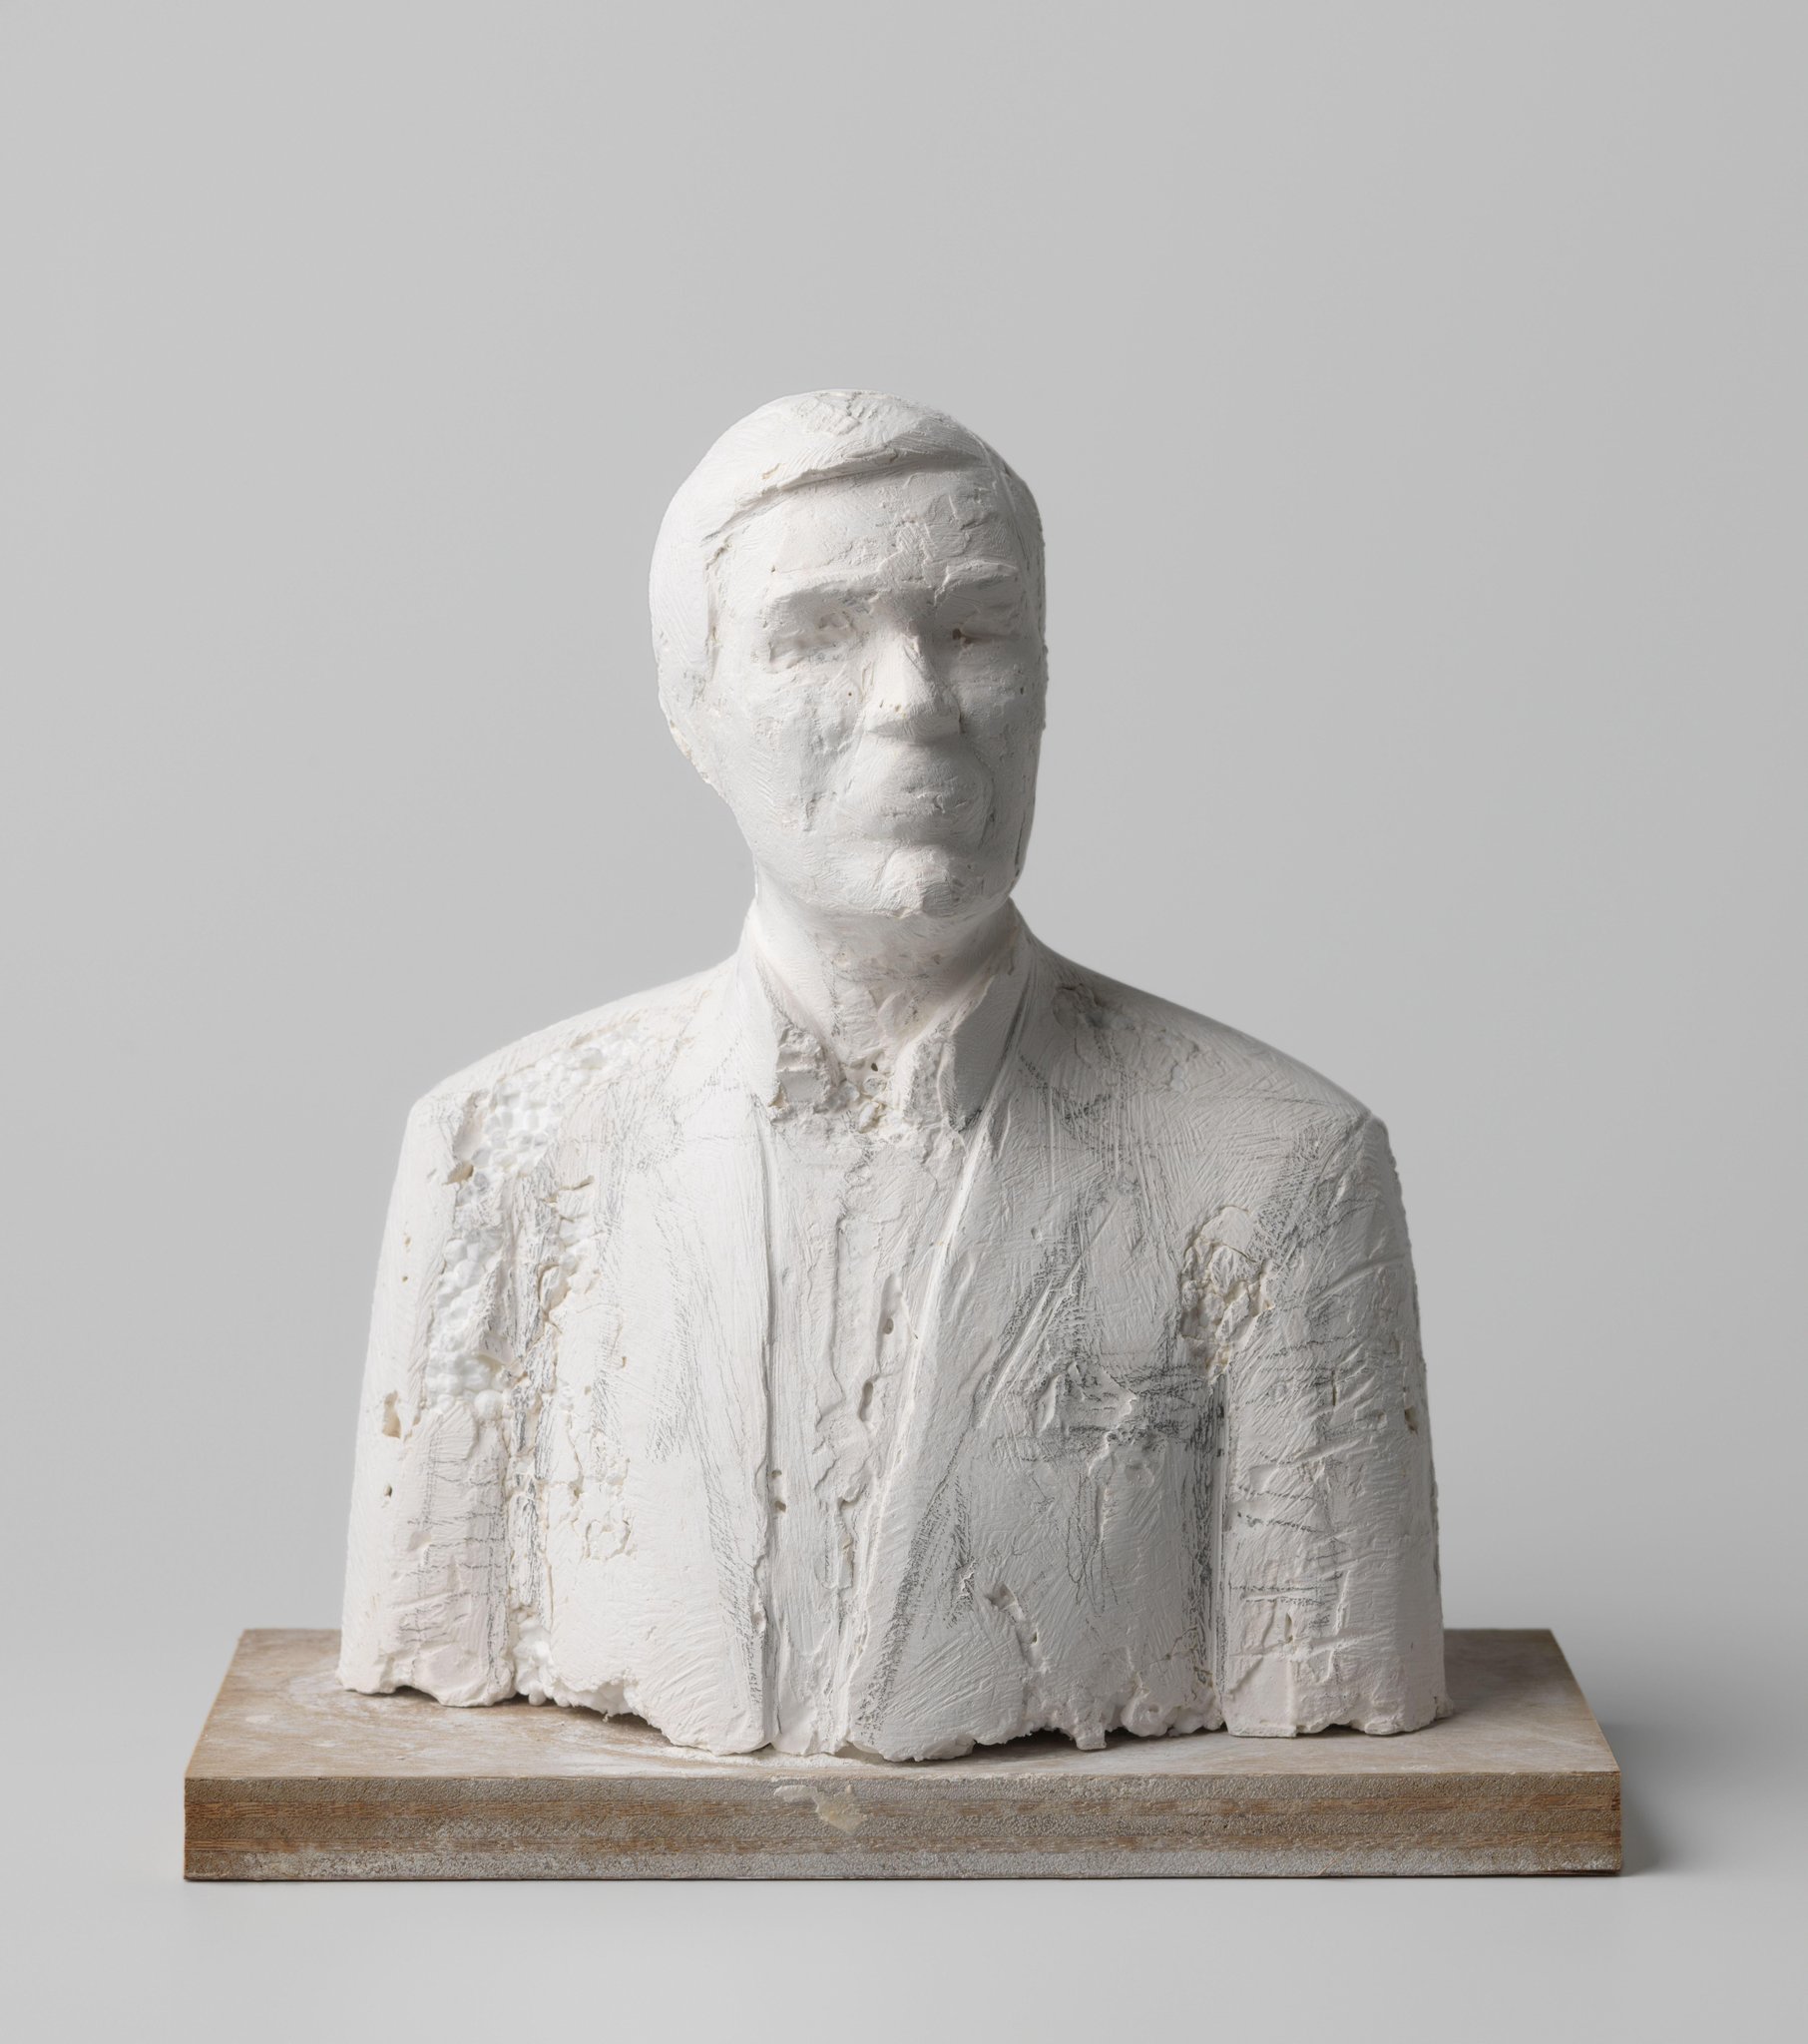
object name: bust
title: Schets van gips voor buste Ronald de Leeuw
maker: tony van de vorst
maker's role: sculptor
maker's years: 1946-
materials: gypsum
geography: vlierden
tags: ronald de leeuw